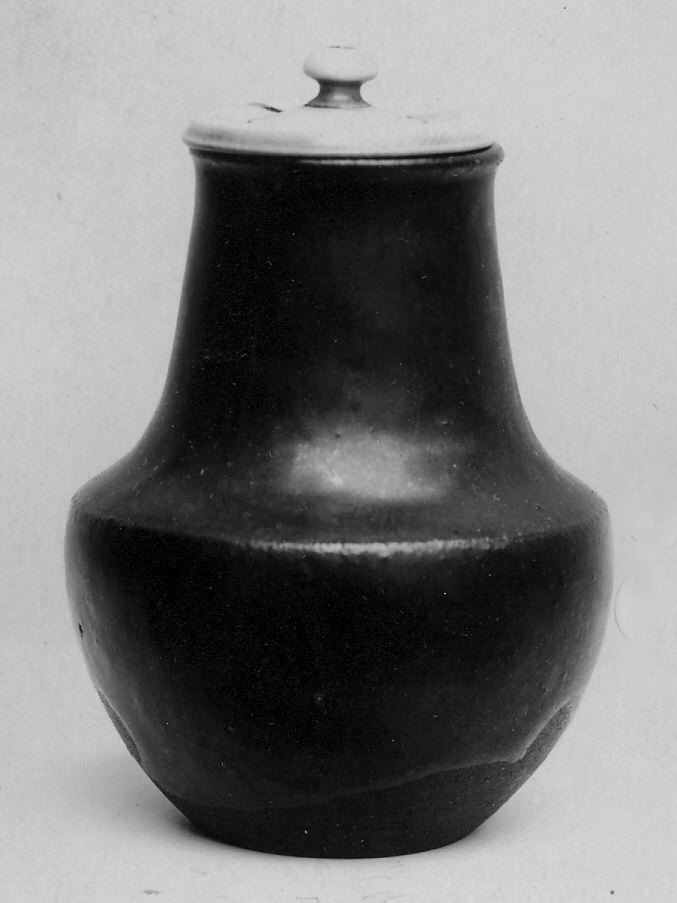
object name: tea jar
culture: japanese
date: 1700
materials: clay, glaze